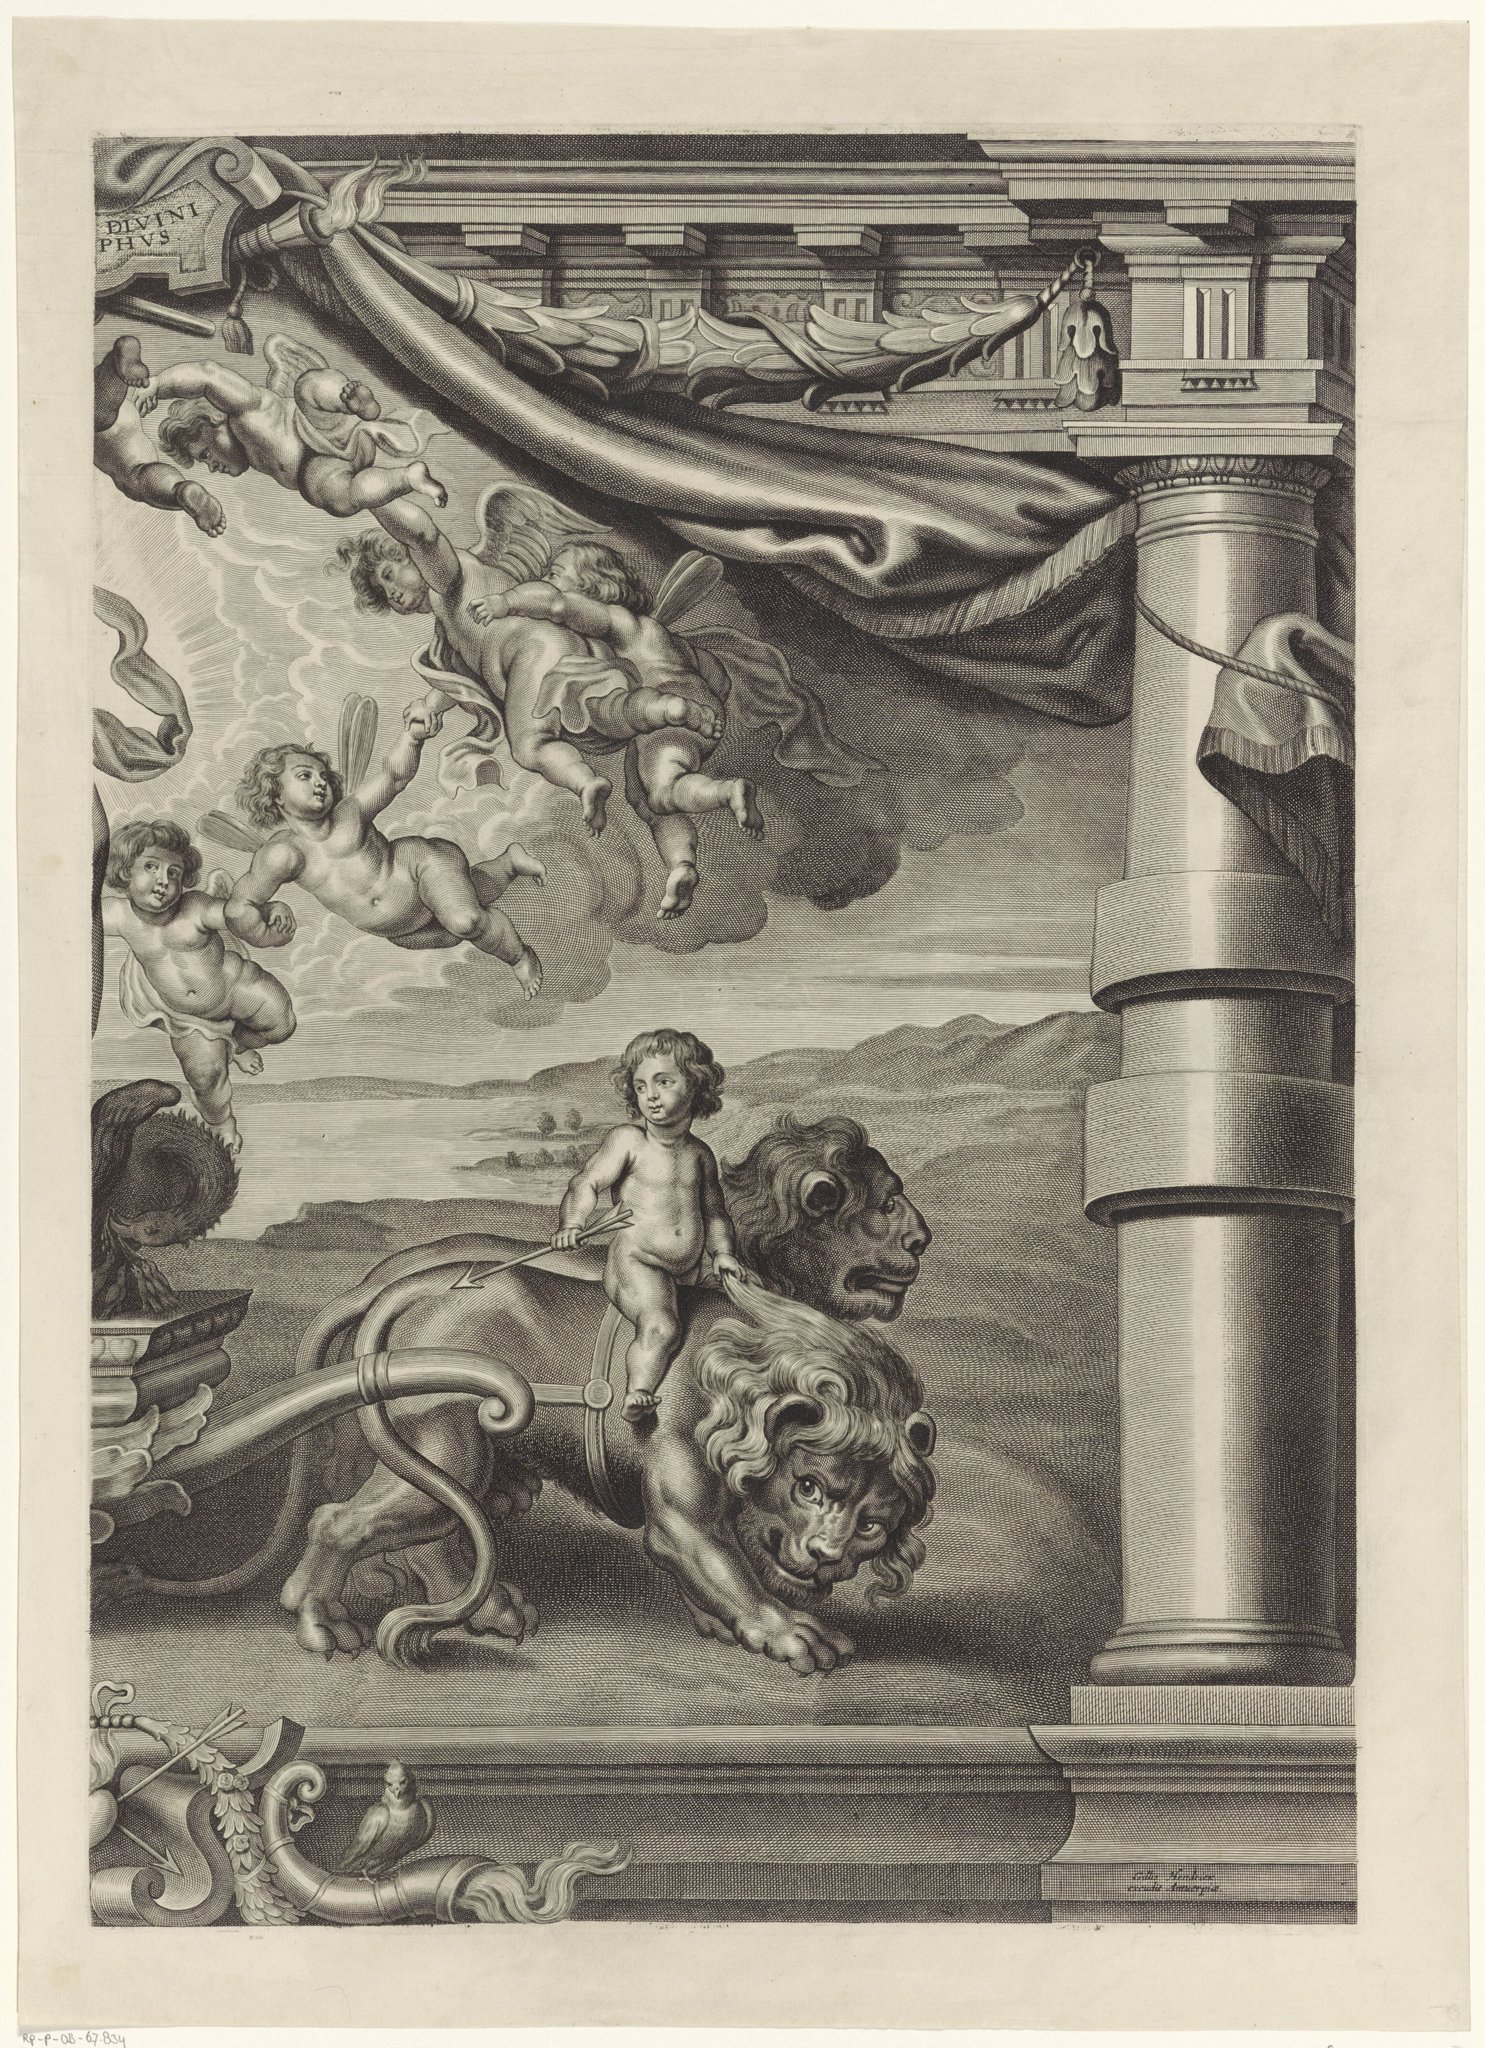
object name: print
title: Triomf van de Goddelijke Liefde (rechter plaat)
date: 1626-1677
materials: paper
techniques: engraving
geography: antwerp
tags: charity, 'caritas'; 'carità' (ripa) ~ one of the three theological virtues - mm - virtues triumphant, heart symbolism, symbols of christ ~ animals, angels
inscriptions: collector's mark: Lugt 240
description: Op een tweewielige kar staat de Goddelijke Liefde (Caritas). Zij houdt een kind tegen de borst gedrukt. Naast haar staan nog twee kinderen die bescherming zoeken. Vooraan op de wagen zit een pelikaan die haar jongen voedt met haar eigen bloed. Boven het hoofd van de Goddelijke Liefde vliegen als in een rondedans een groep engeltjes waarvan de voorste een fakkel vasthoudt. Achter de wagen lopen twee engelen, De ene houdt een brandend hart in de lucht, de andere bedreigt met een fakkel twee kronkelende slangen, symbool van de haat.